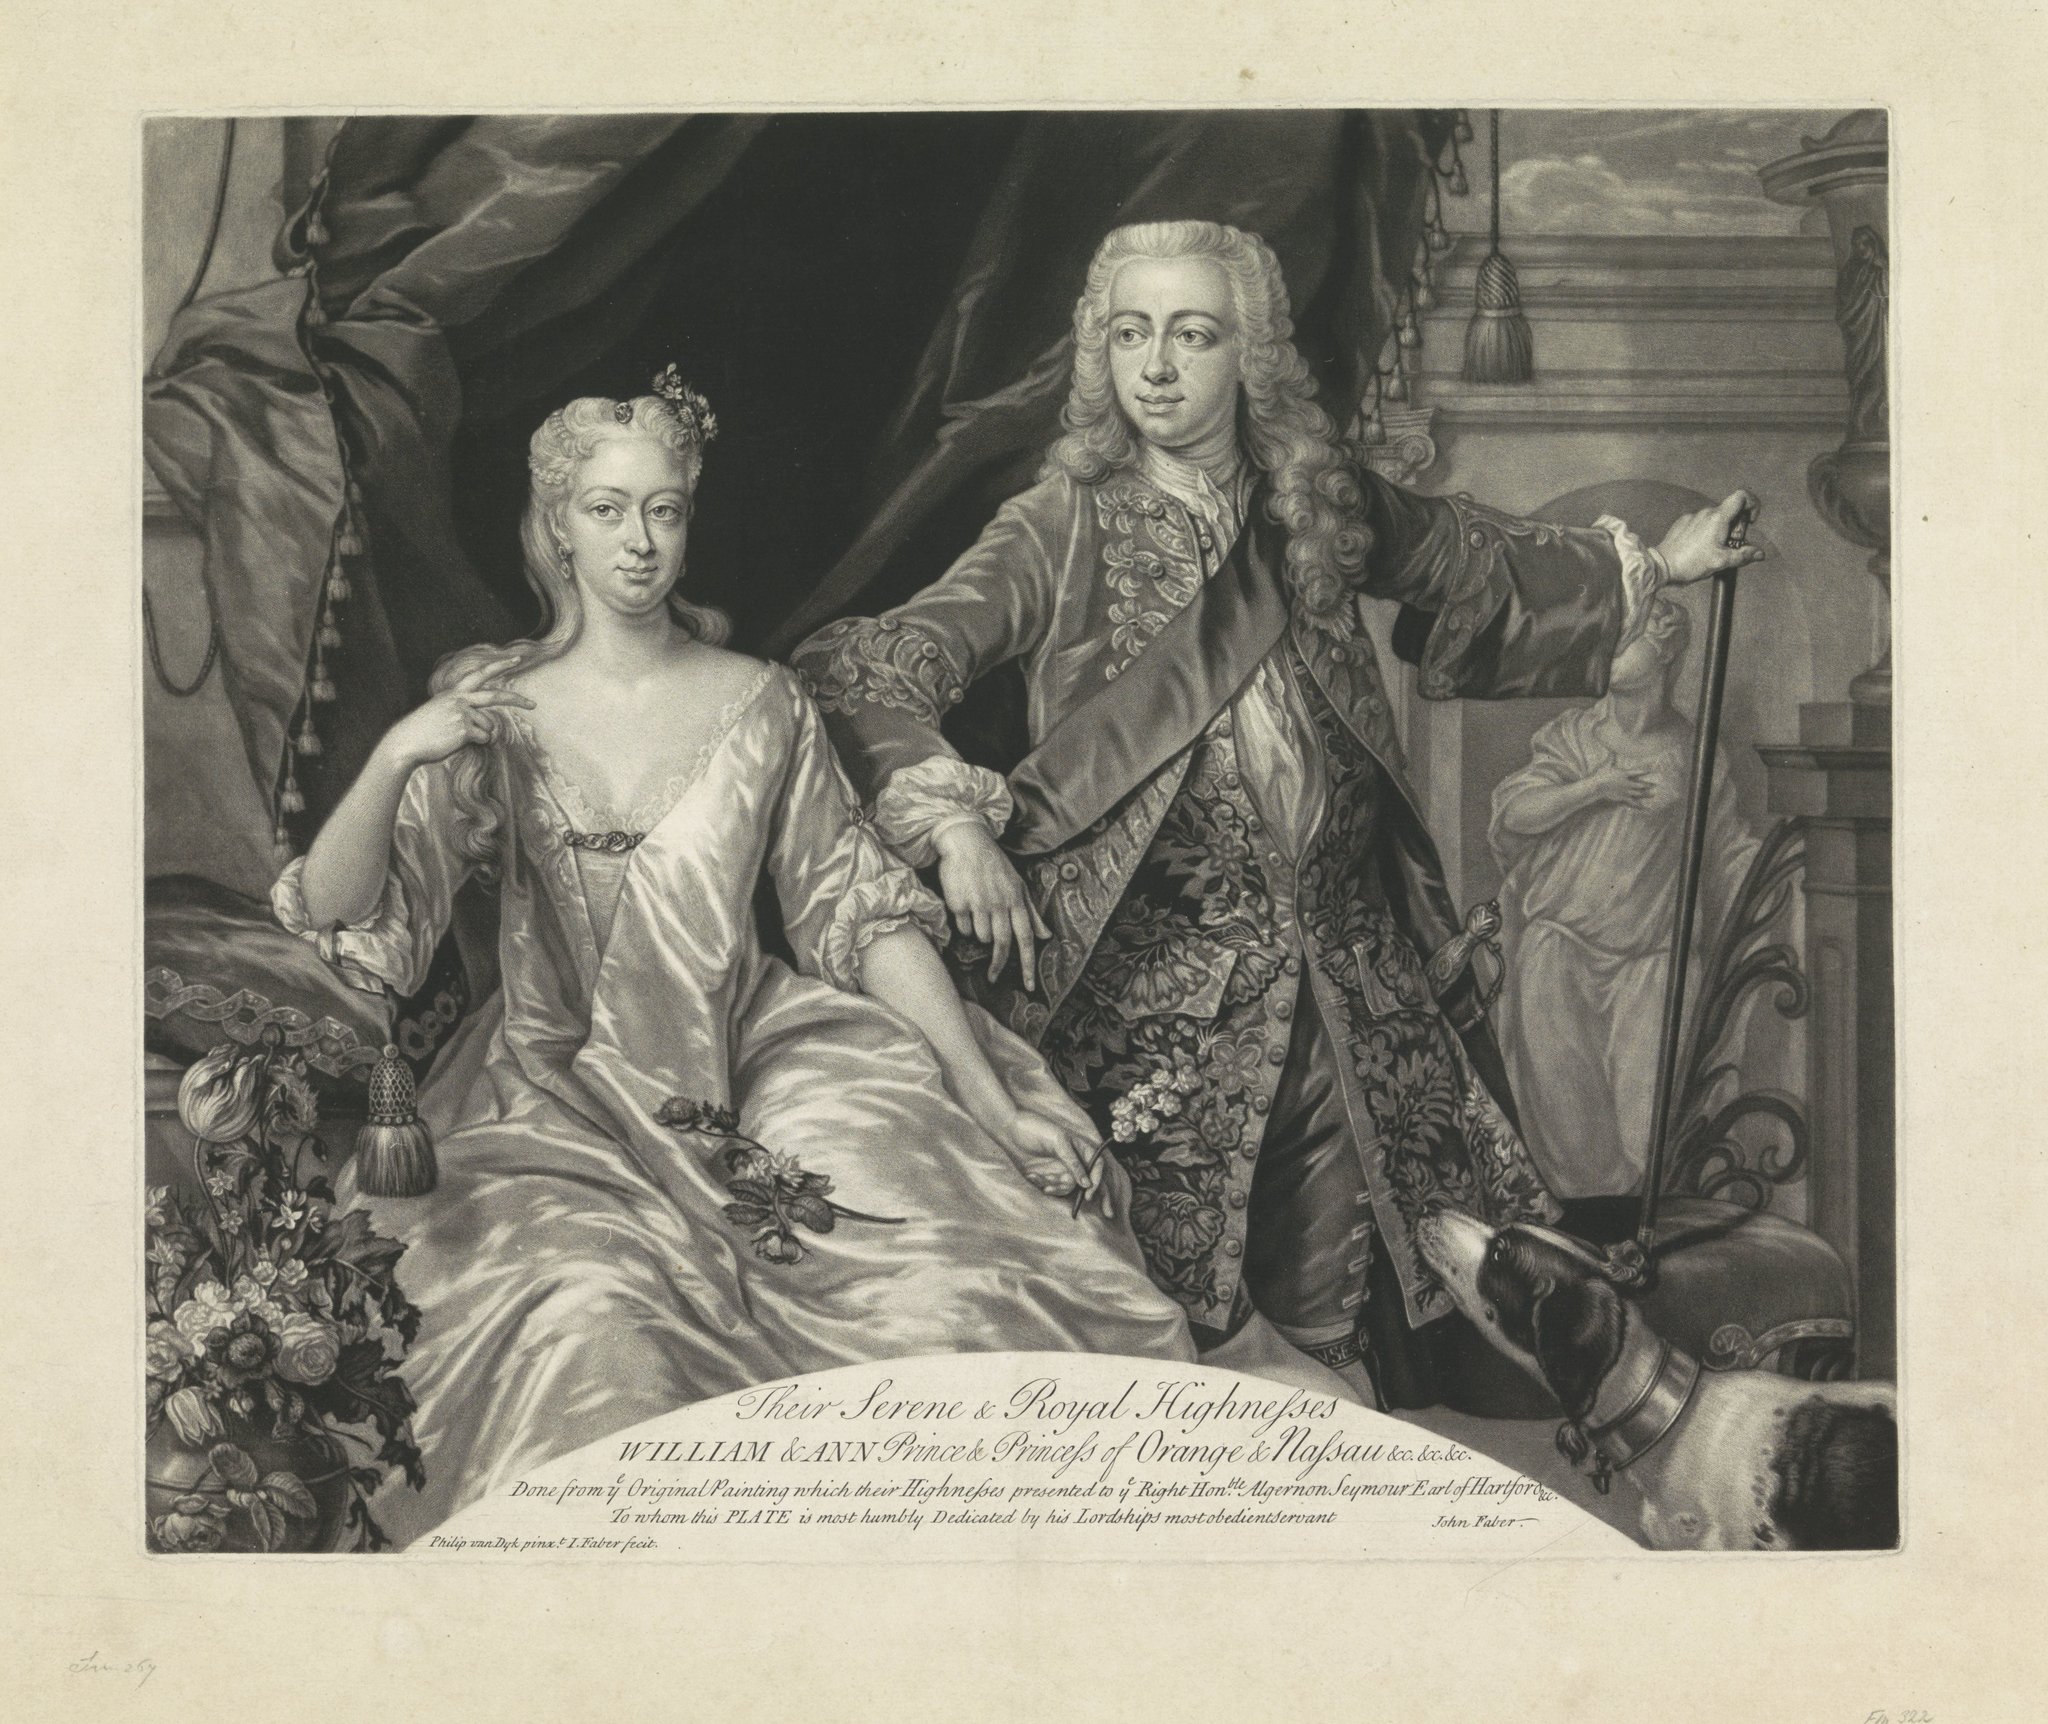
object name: print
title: Portret van Willem IV, prins van Oranje-Nassau, en Anna van Hannover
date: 1734-1756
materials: paper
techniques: mezzotint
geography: london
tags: the hague, willem iv (prins van oranje-nassau), anna van hannover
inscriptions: collector's mark: Lugt 240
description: De hier vermelde titel verwijst naar de hoogst verkregen titel van de geportretteerde, niet per se naar de titel die de geportretteerde op deze voorstelling draagt.